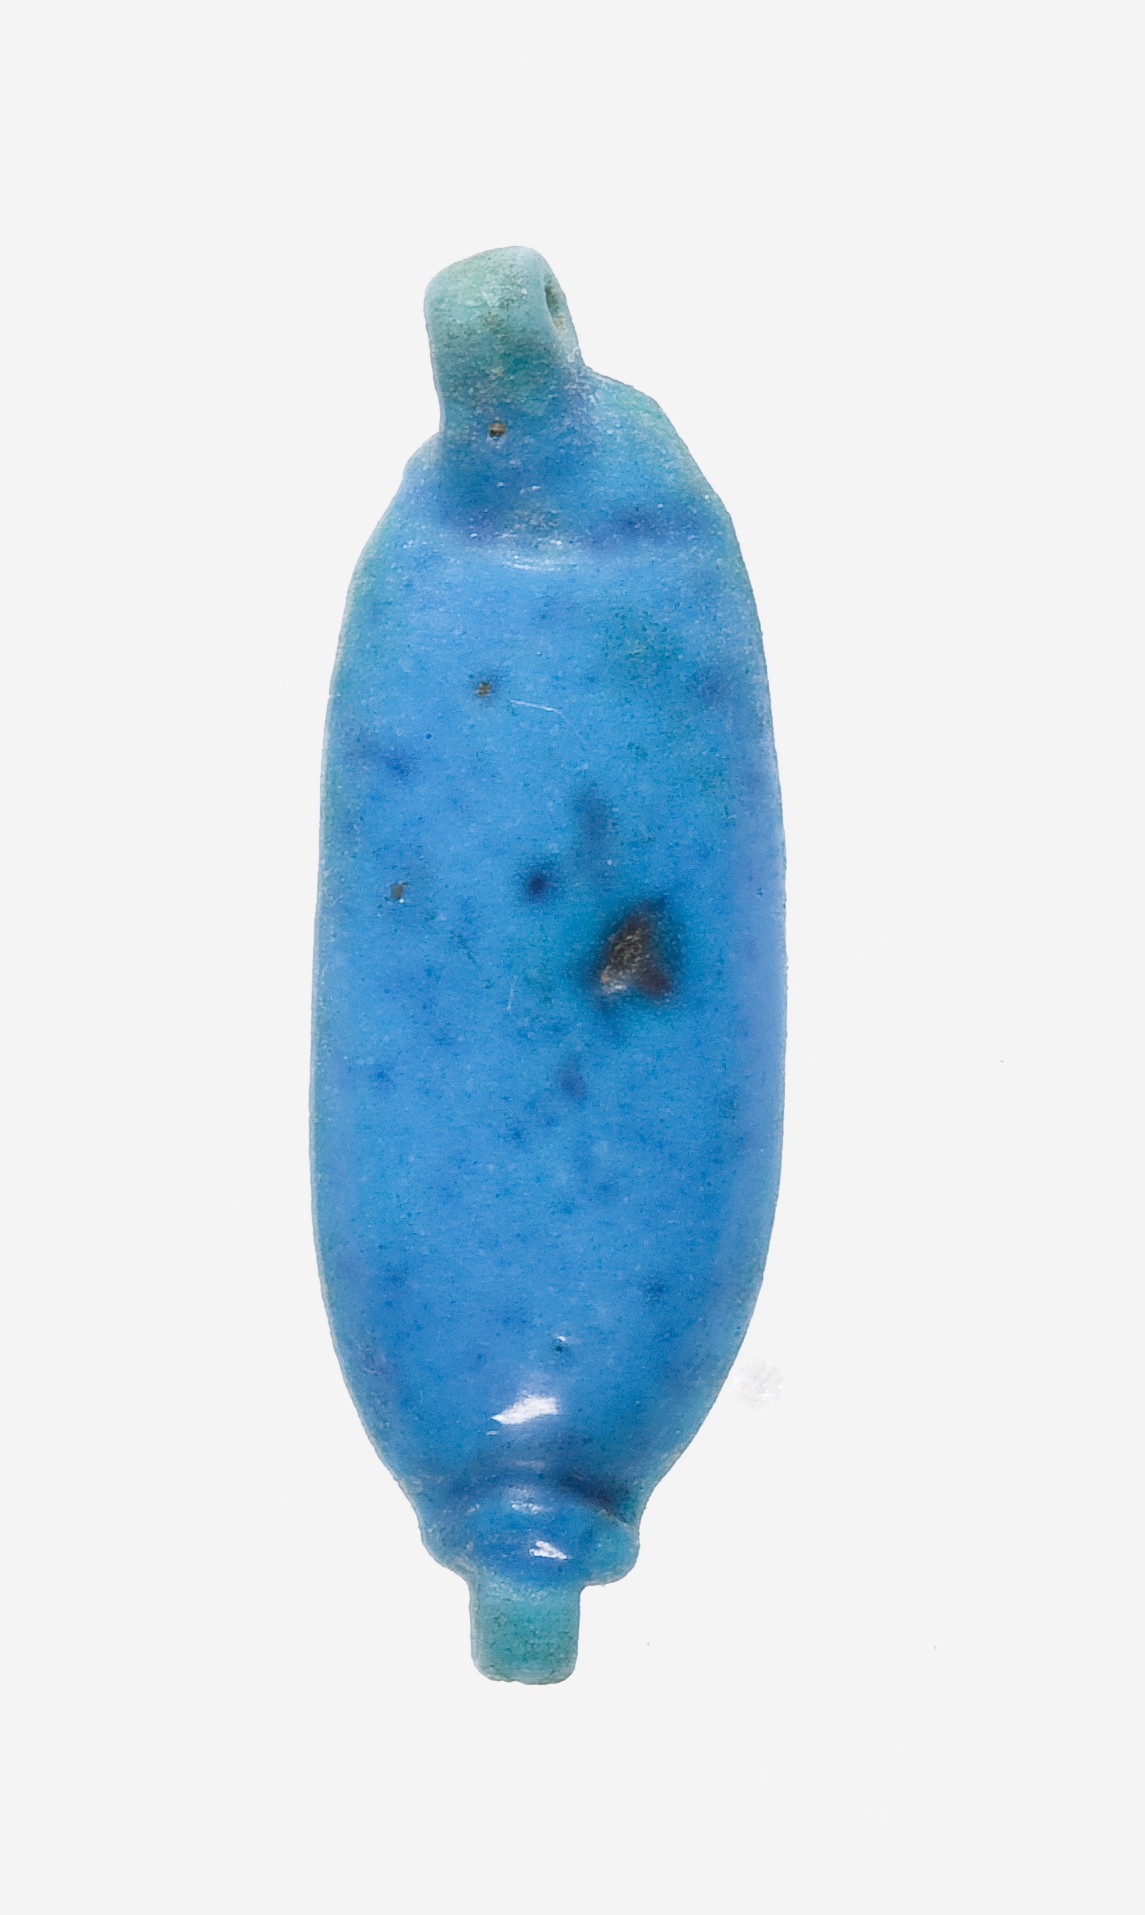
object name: pendant, lotus petal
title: Oval Pendant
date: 1390-1352 BCE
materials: faience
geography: egypt